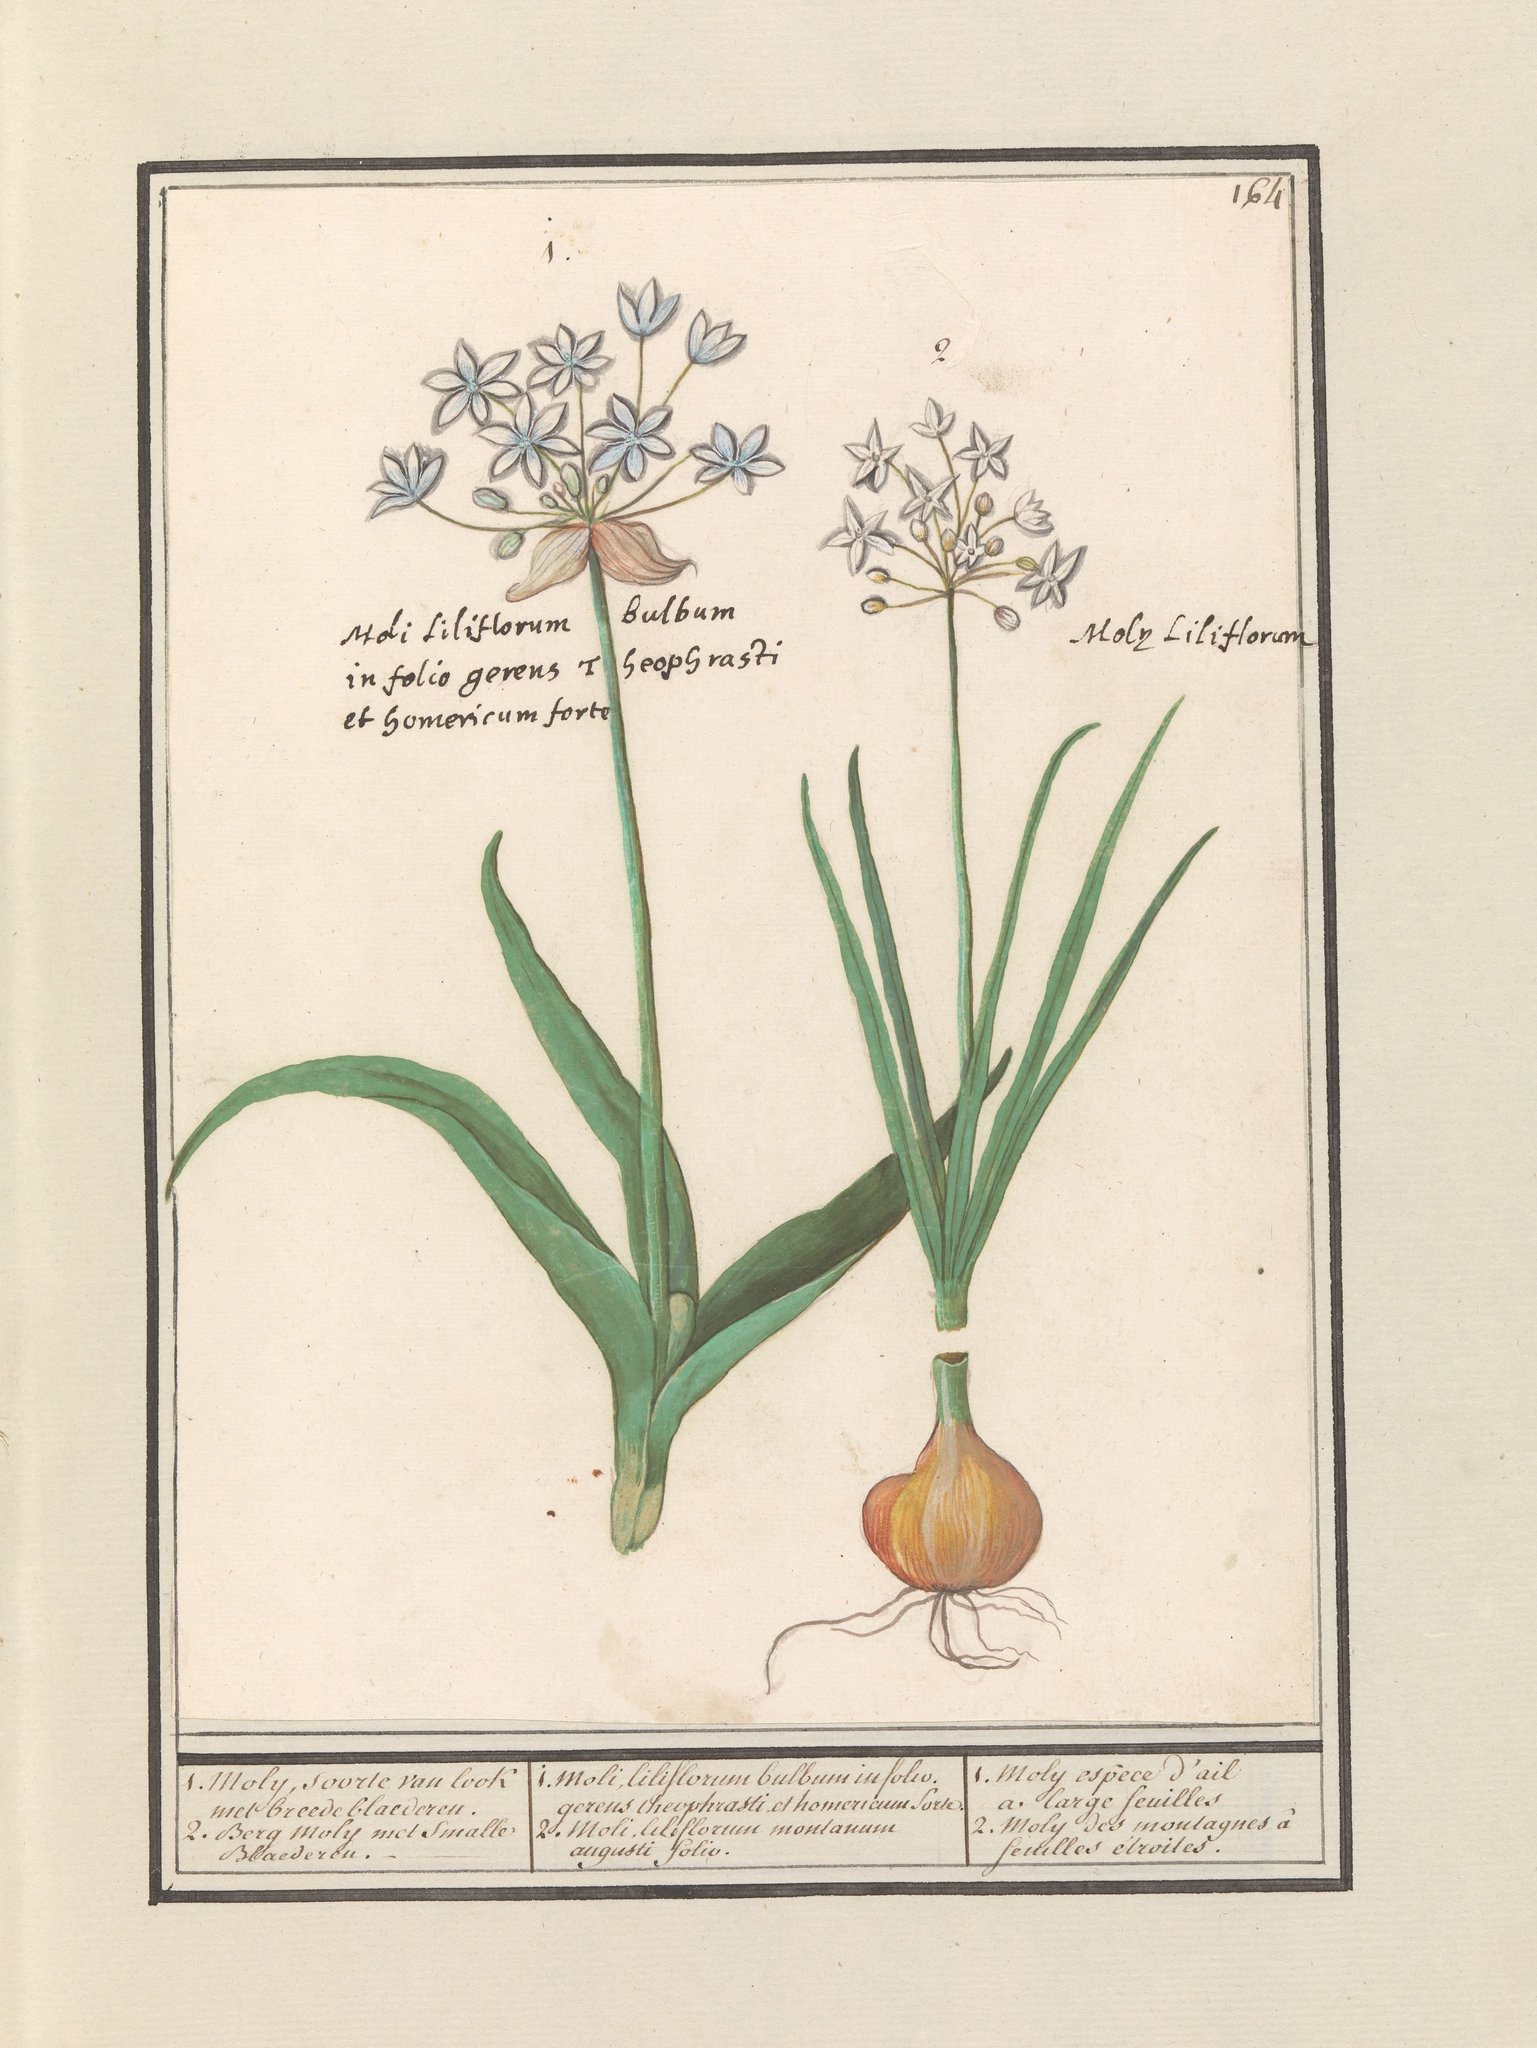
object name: drawing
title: Daslook (Allium ursinum)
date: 1596-1610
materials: chalk, paint, ink, paper, watercolor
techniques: brush, pen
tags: flowers: ramsoms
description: Daslook. Rechtsboven genummerd: 164. BIj de bloemen de Latijnse namen. Onderdeel van het tweede album met tekeningen van bloemen en planten. Negende van twaalf albums met tekeningen van dieren, vogels en planten bekend rond 1600, gemaakt in opdracht van keizer Rudolf II. Met toelichting in Nederlands, Latijn en Frans.